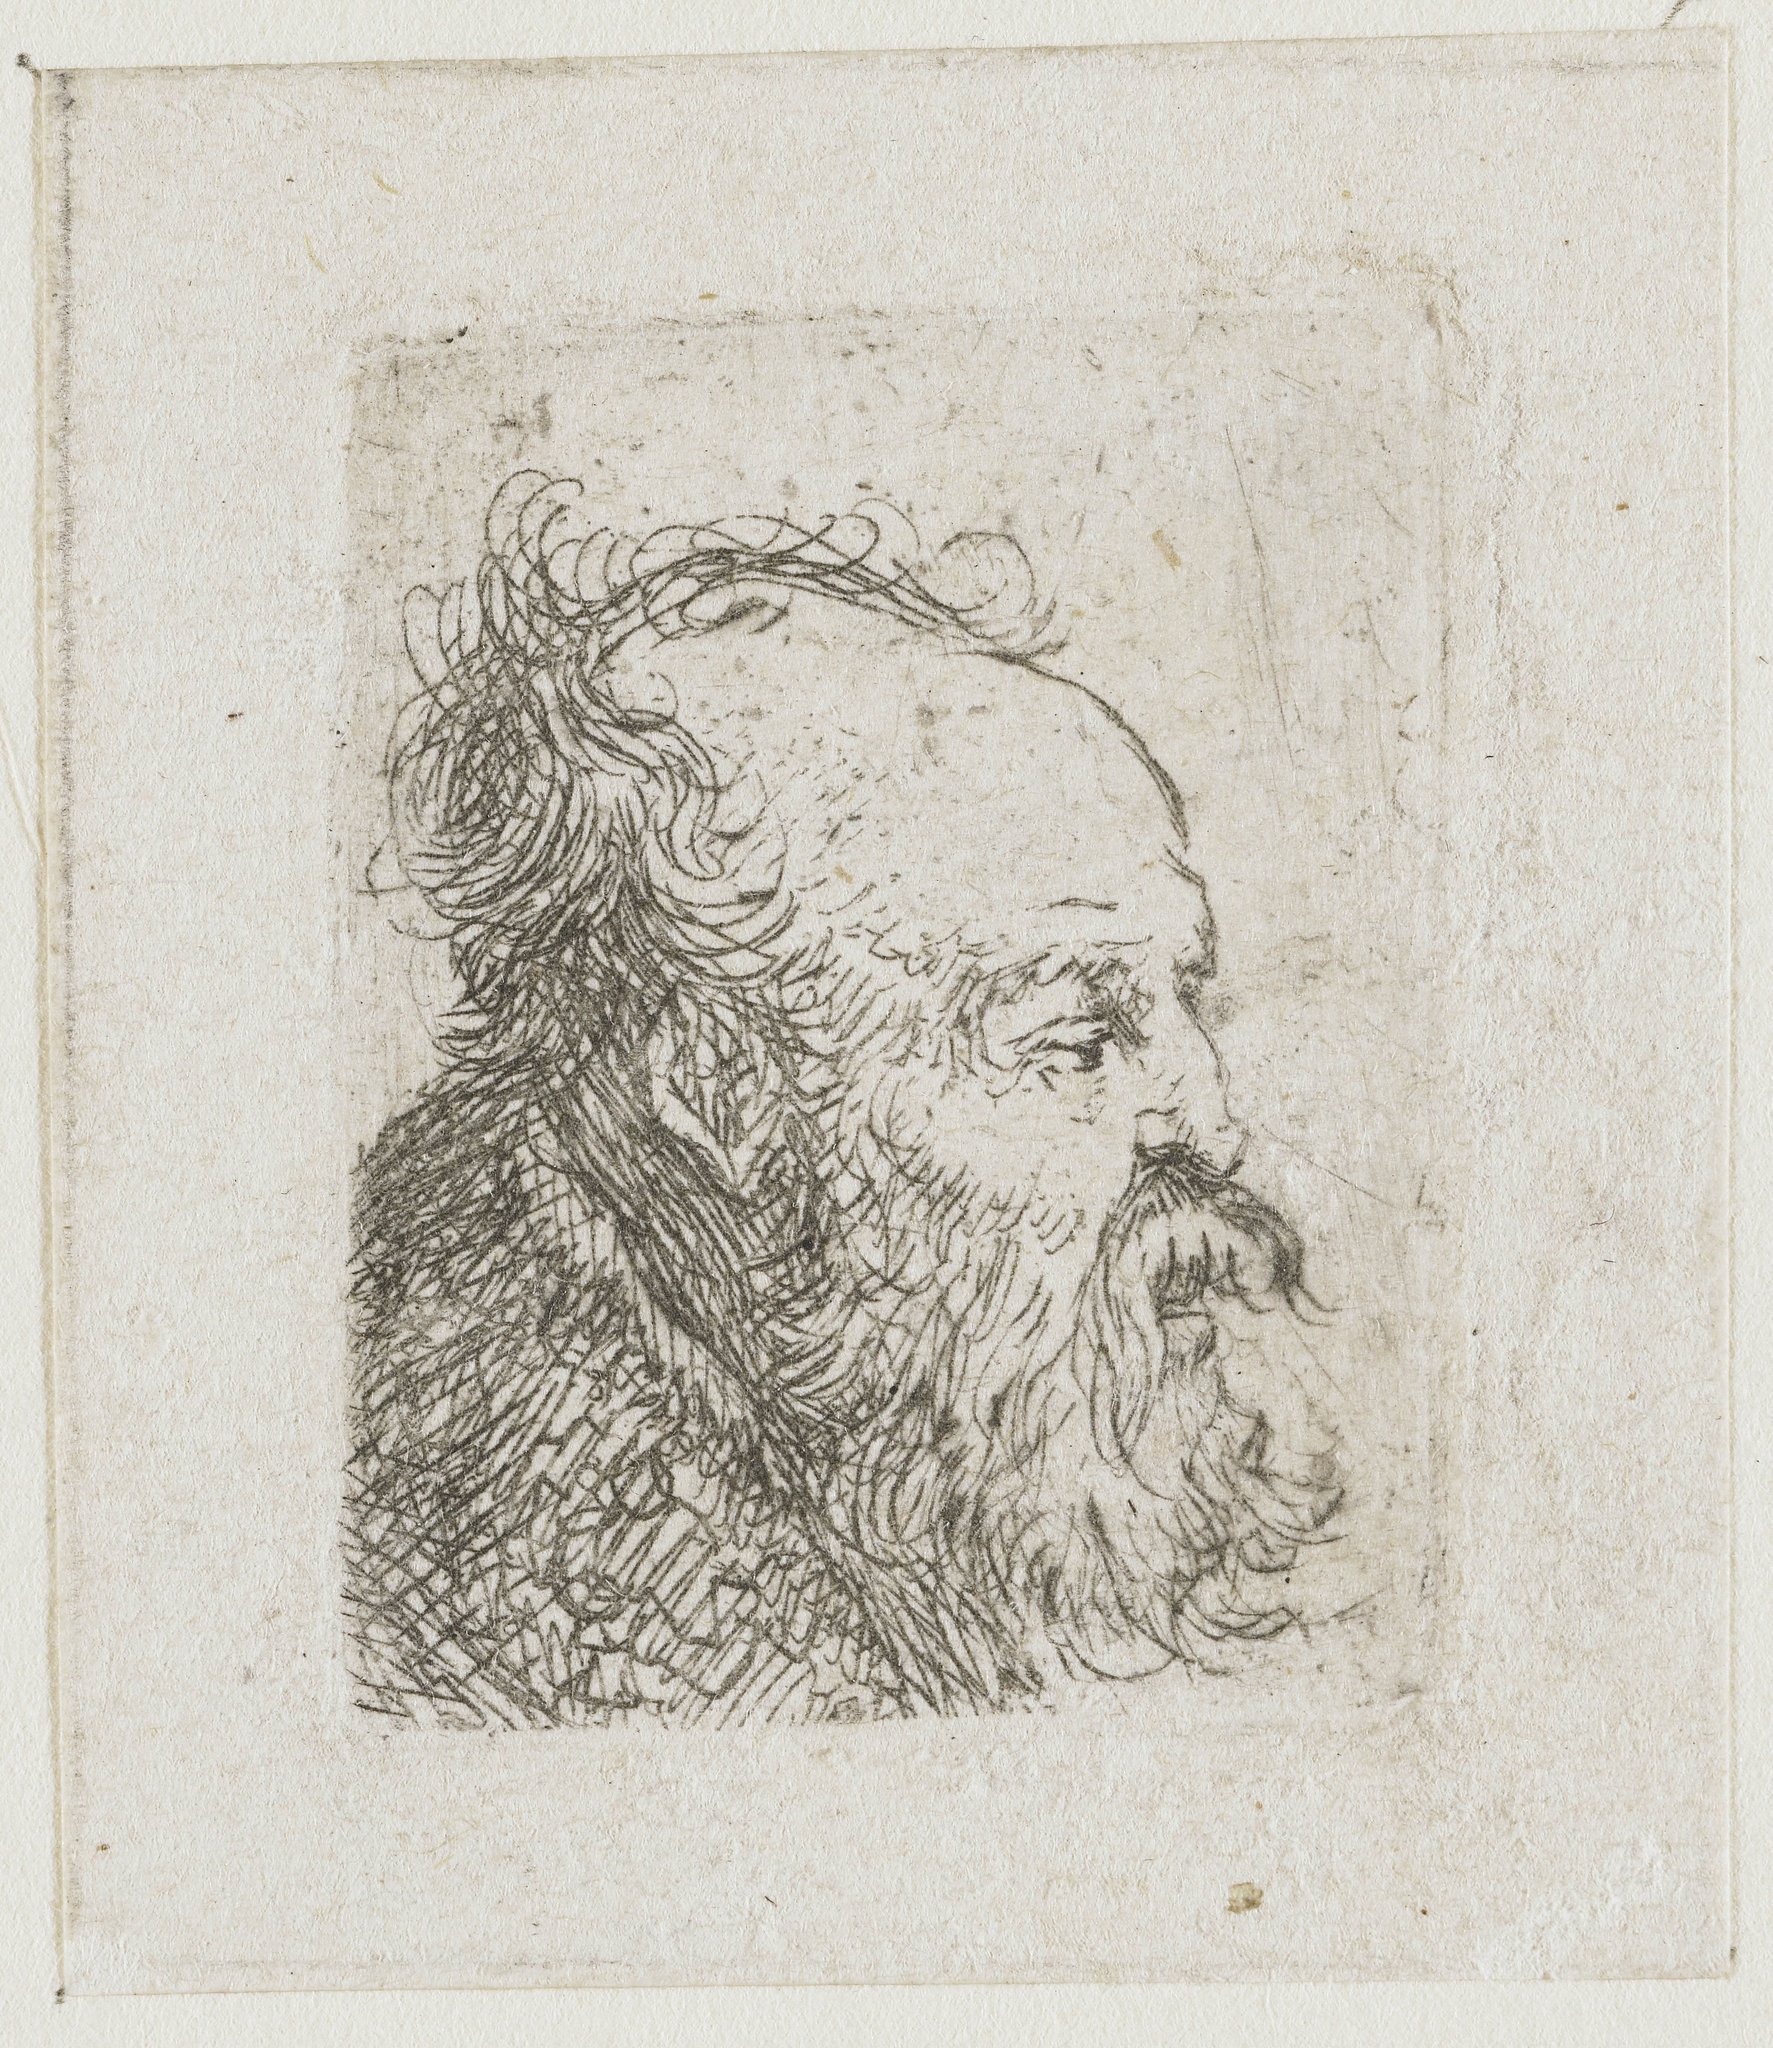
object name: print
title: Sheet of studies of men's heads: old bearded man nearly in profile to right: mouth half open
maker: rembrandt van rijn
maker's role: draughtsman, painter, print maker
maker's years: 1606-1669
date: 1629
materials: paper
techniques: etching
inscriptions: collector's mark: Lugt 240